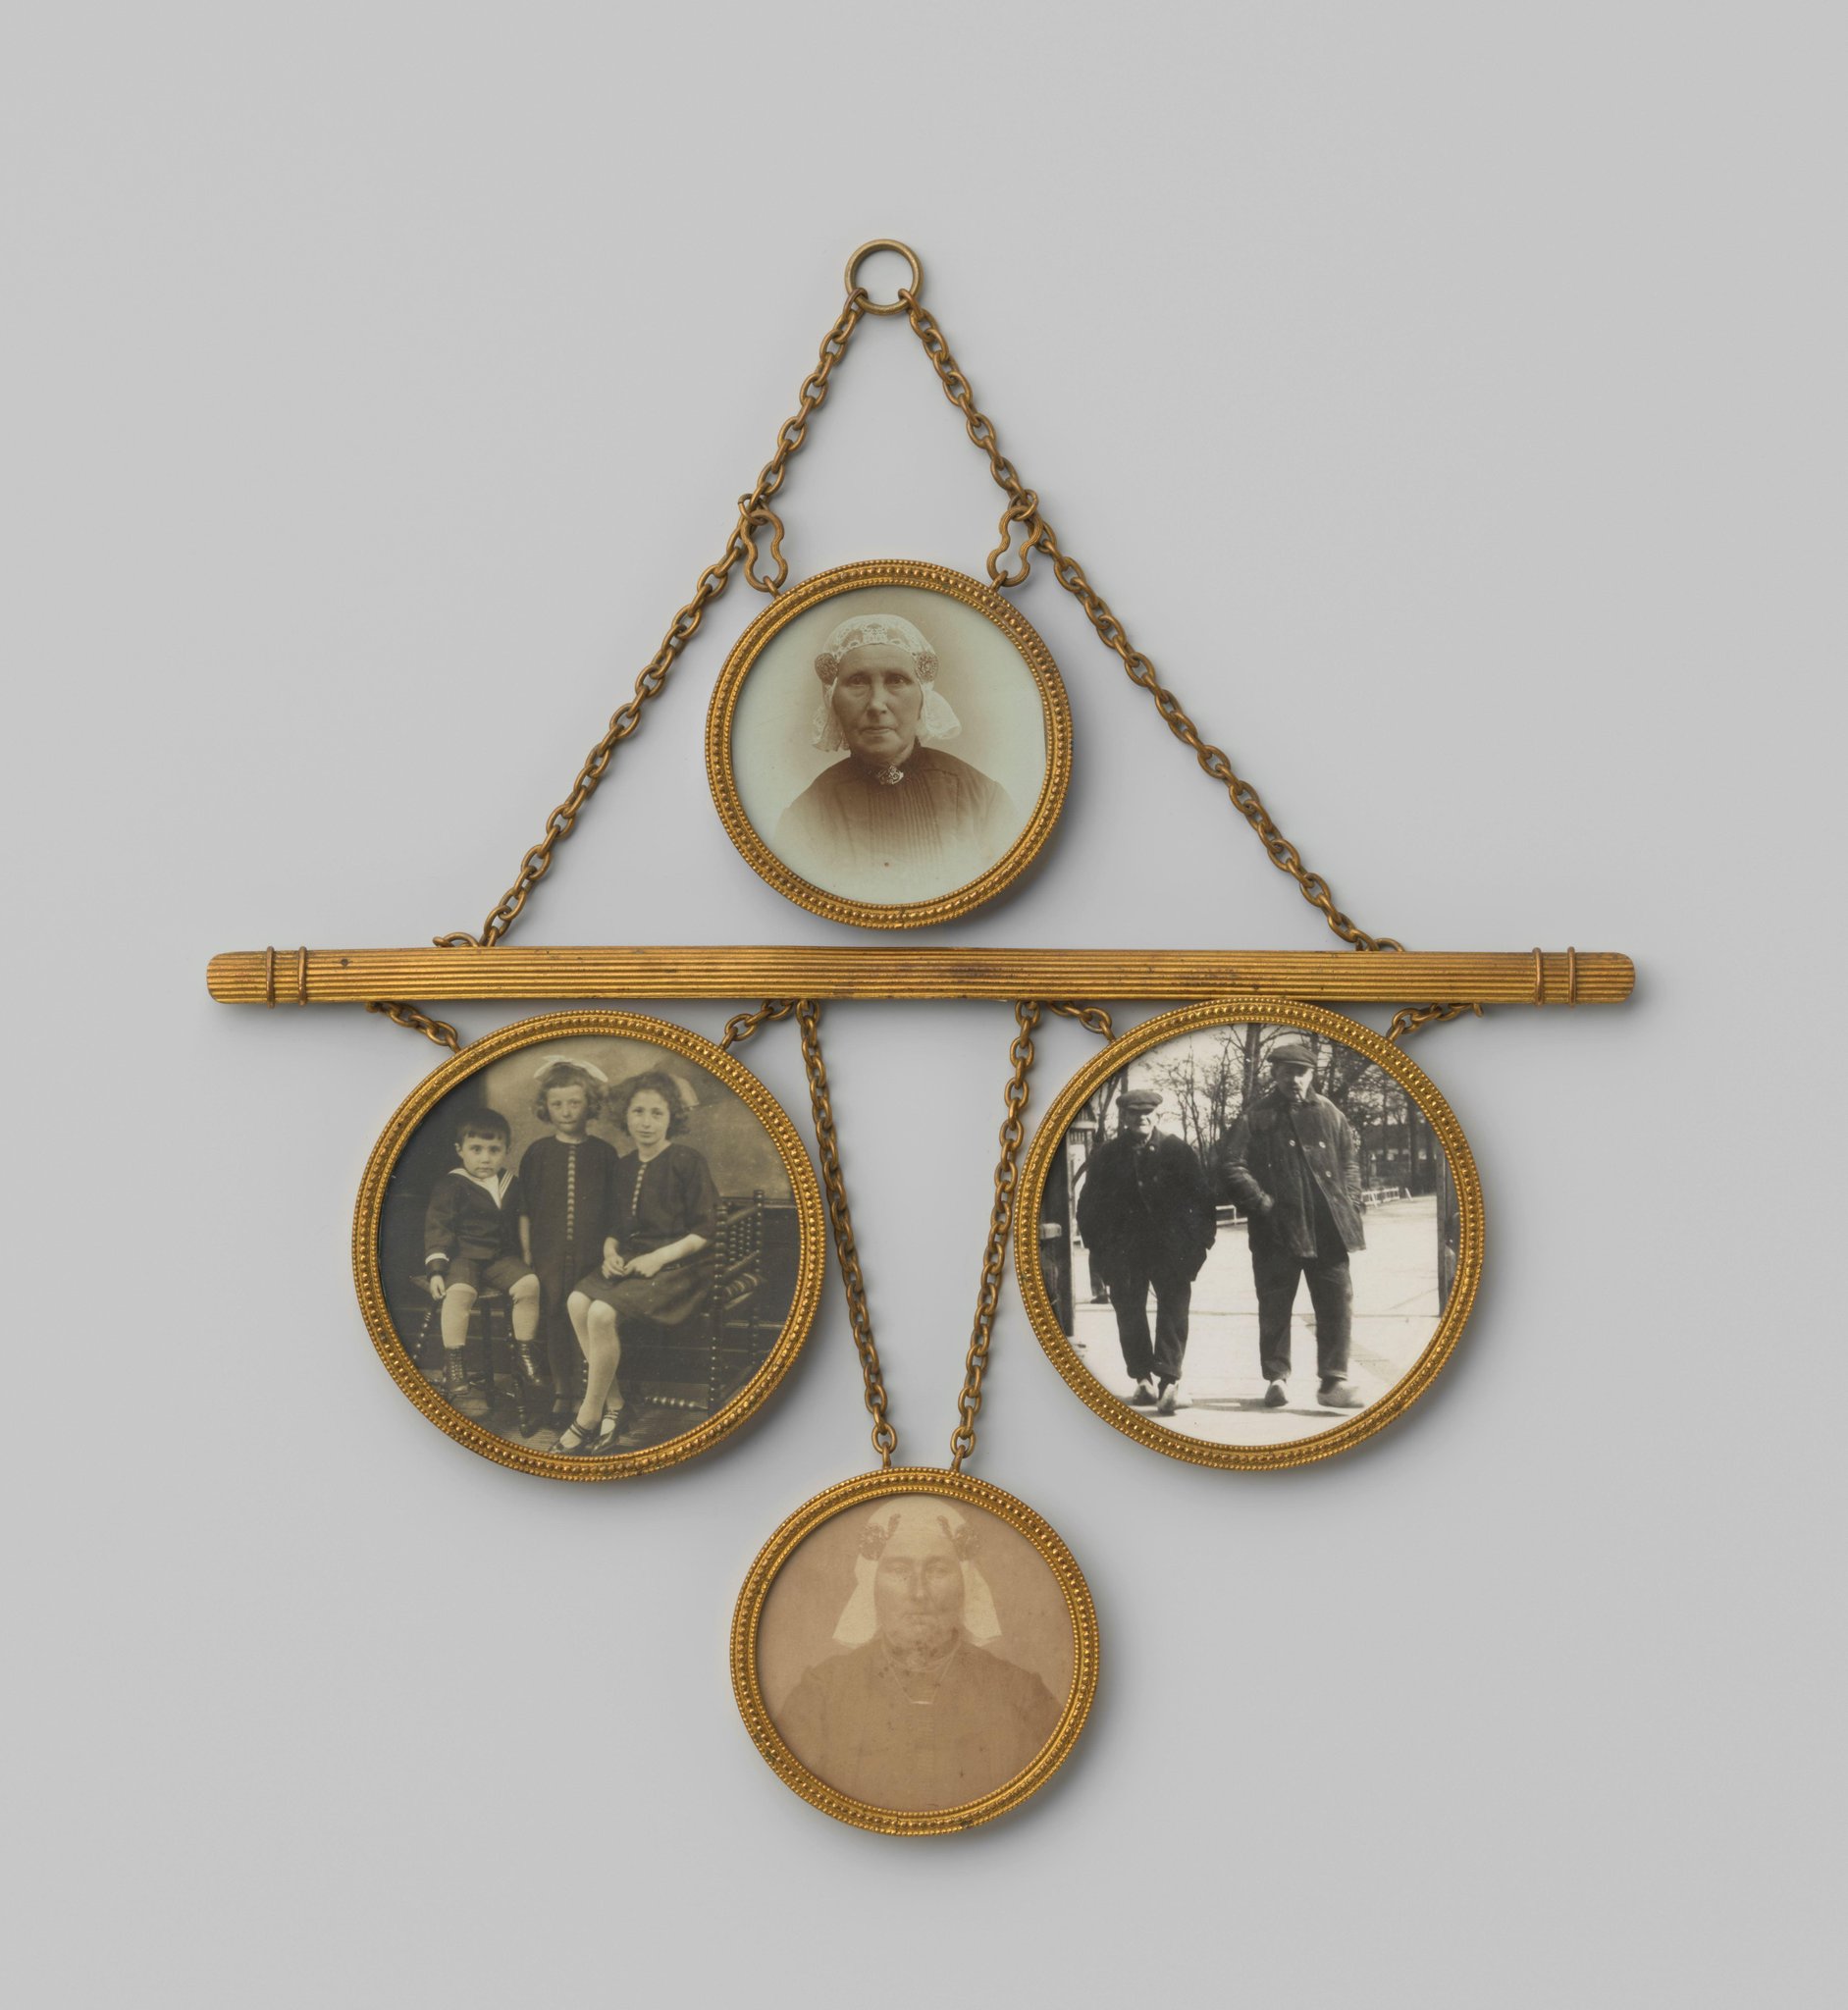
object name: photograph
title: Portret van twee onbekende meisjes en een onbekende jongen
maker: Anonymous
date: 1900-1920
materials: paper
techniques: gelatin silver print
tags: ensemble of pieces of clothing: sailor suit, boy (child between toddler and youth), girl (child between toddler and youth), anonymous historical person portrayed